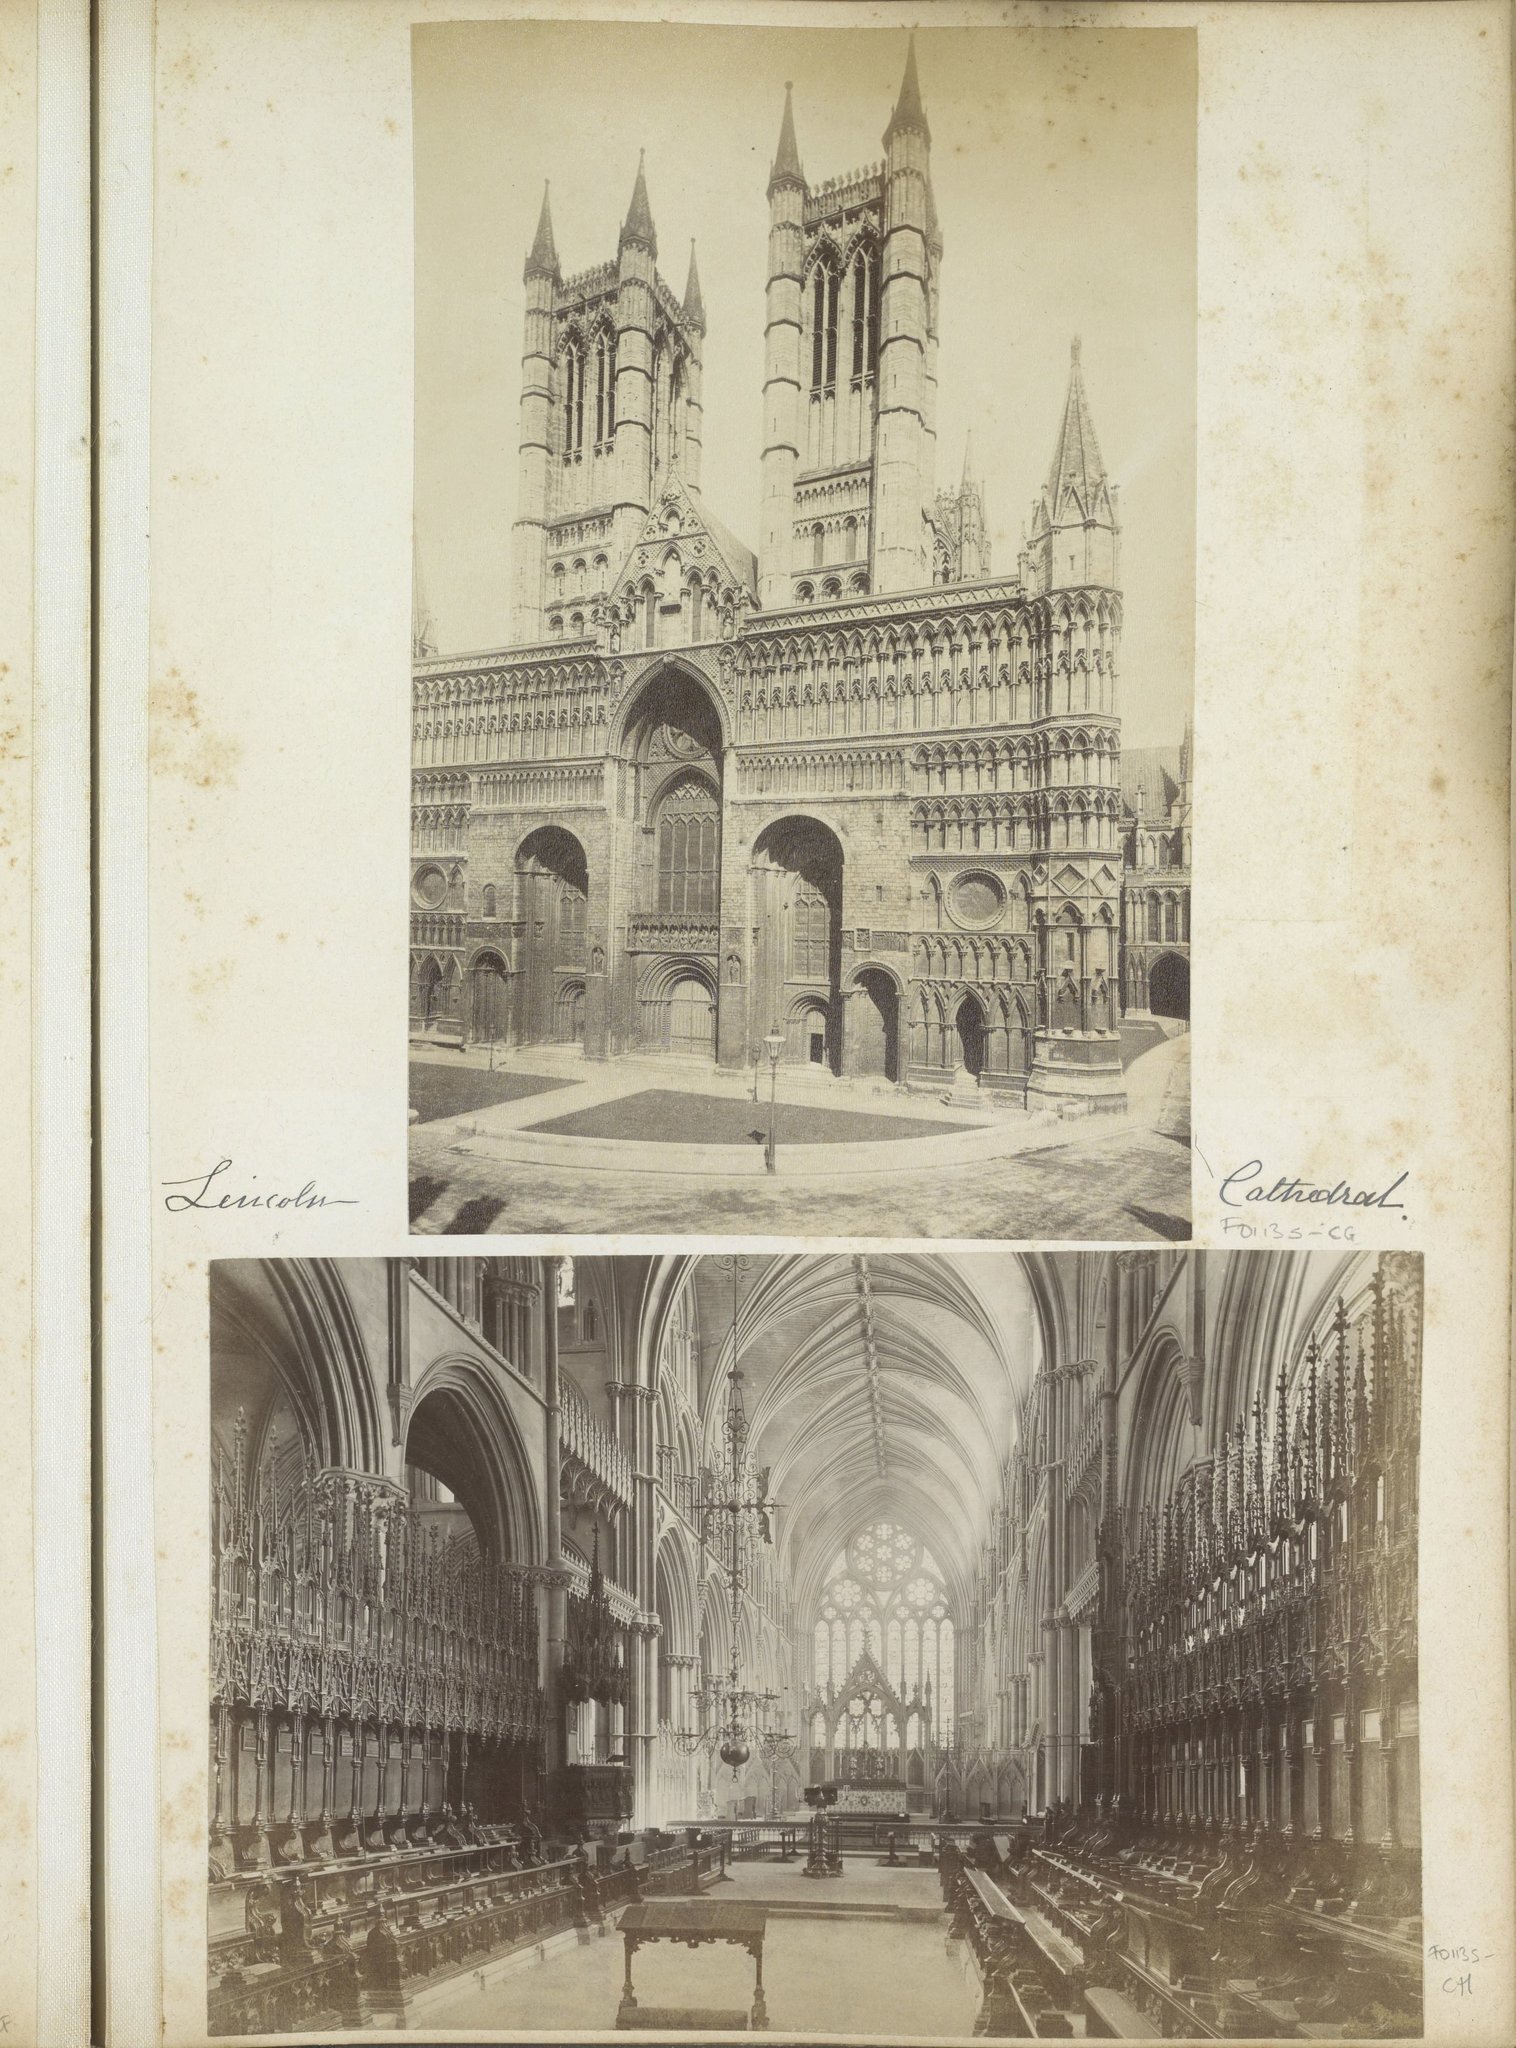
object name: photograph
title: Interieur van de Kathedraal van Lincoln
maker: Anonymous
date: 1900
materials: paper, photographic support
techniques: albumen print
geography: lincoln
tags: parts of church interior: choir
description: Onderdeel van Reisalbum met foto's van bezienswaardigheden in Engeland en Frankrijk.